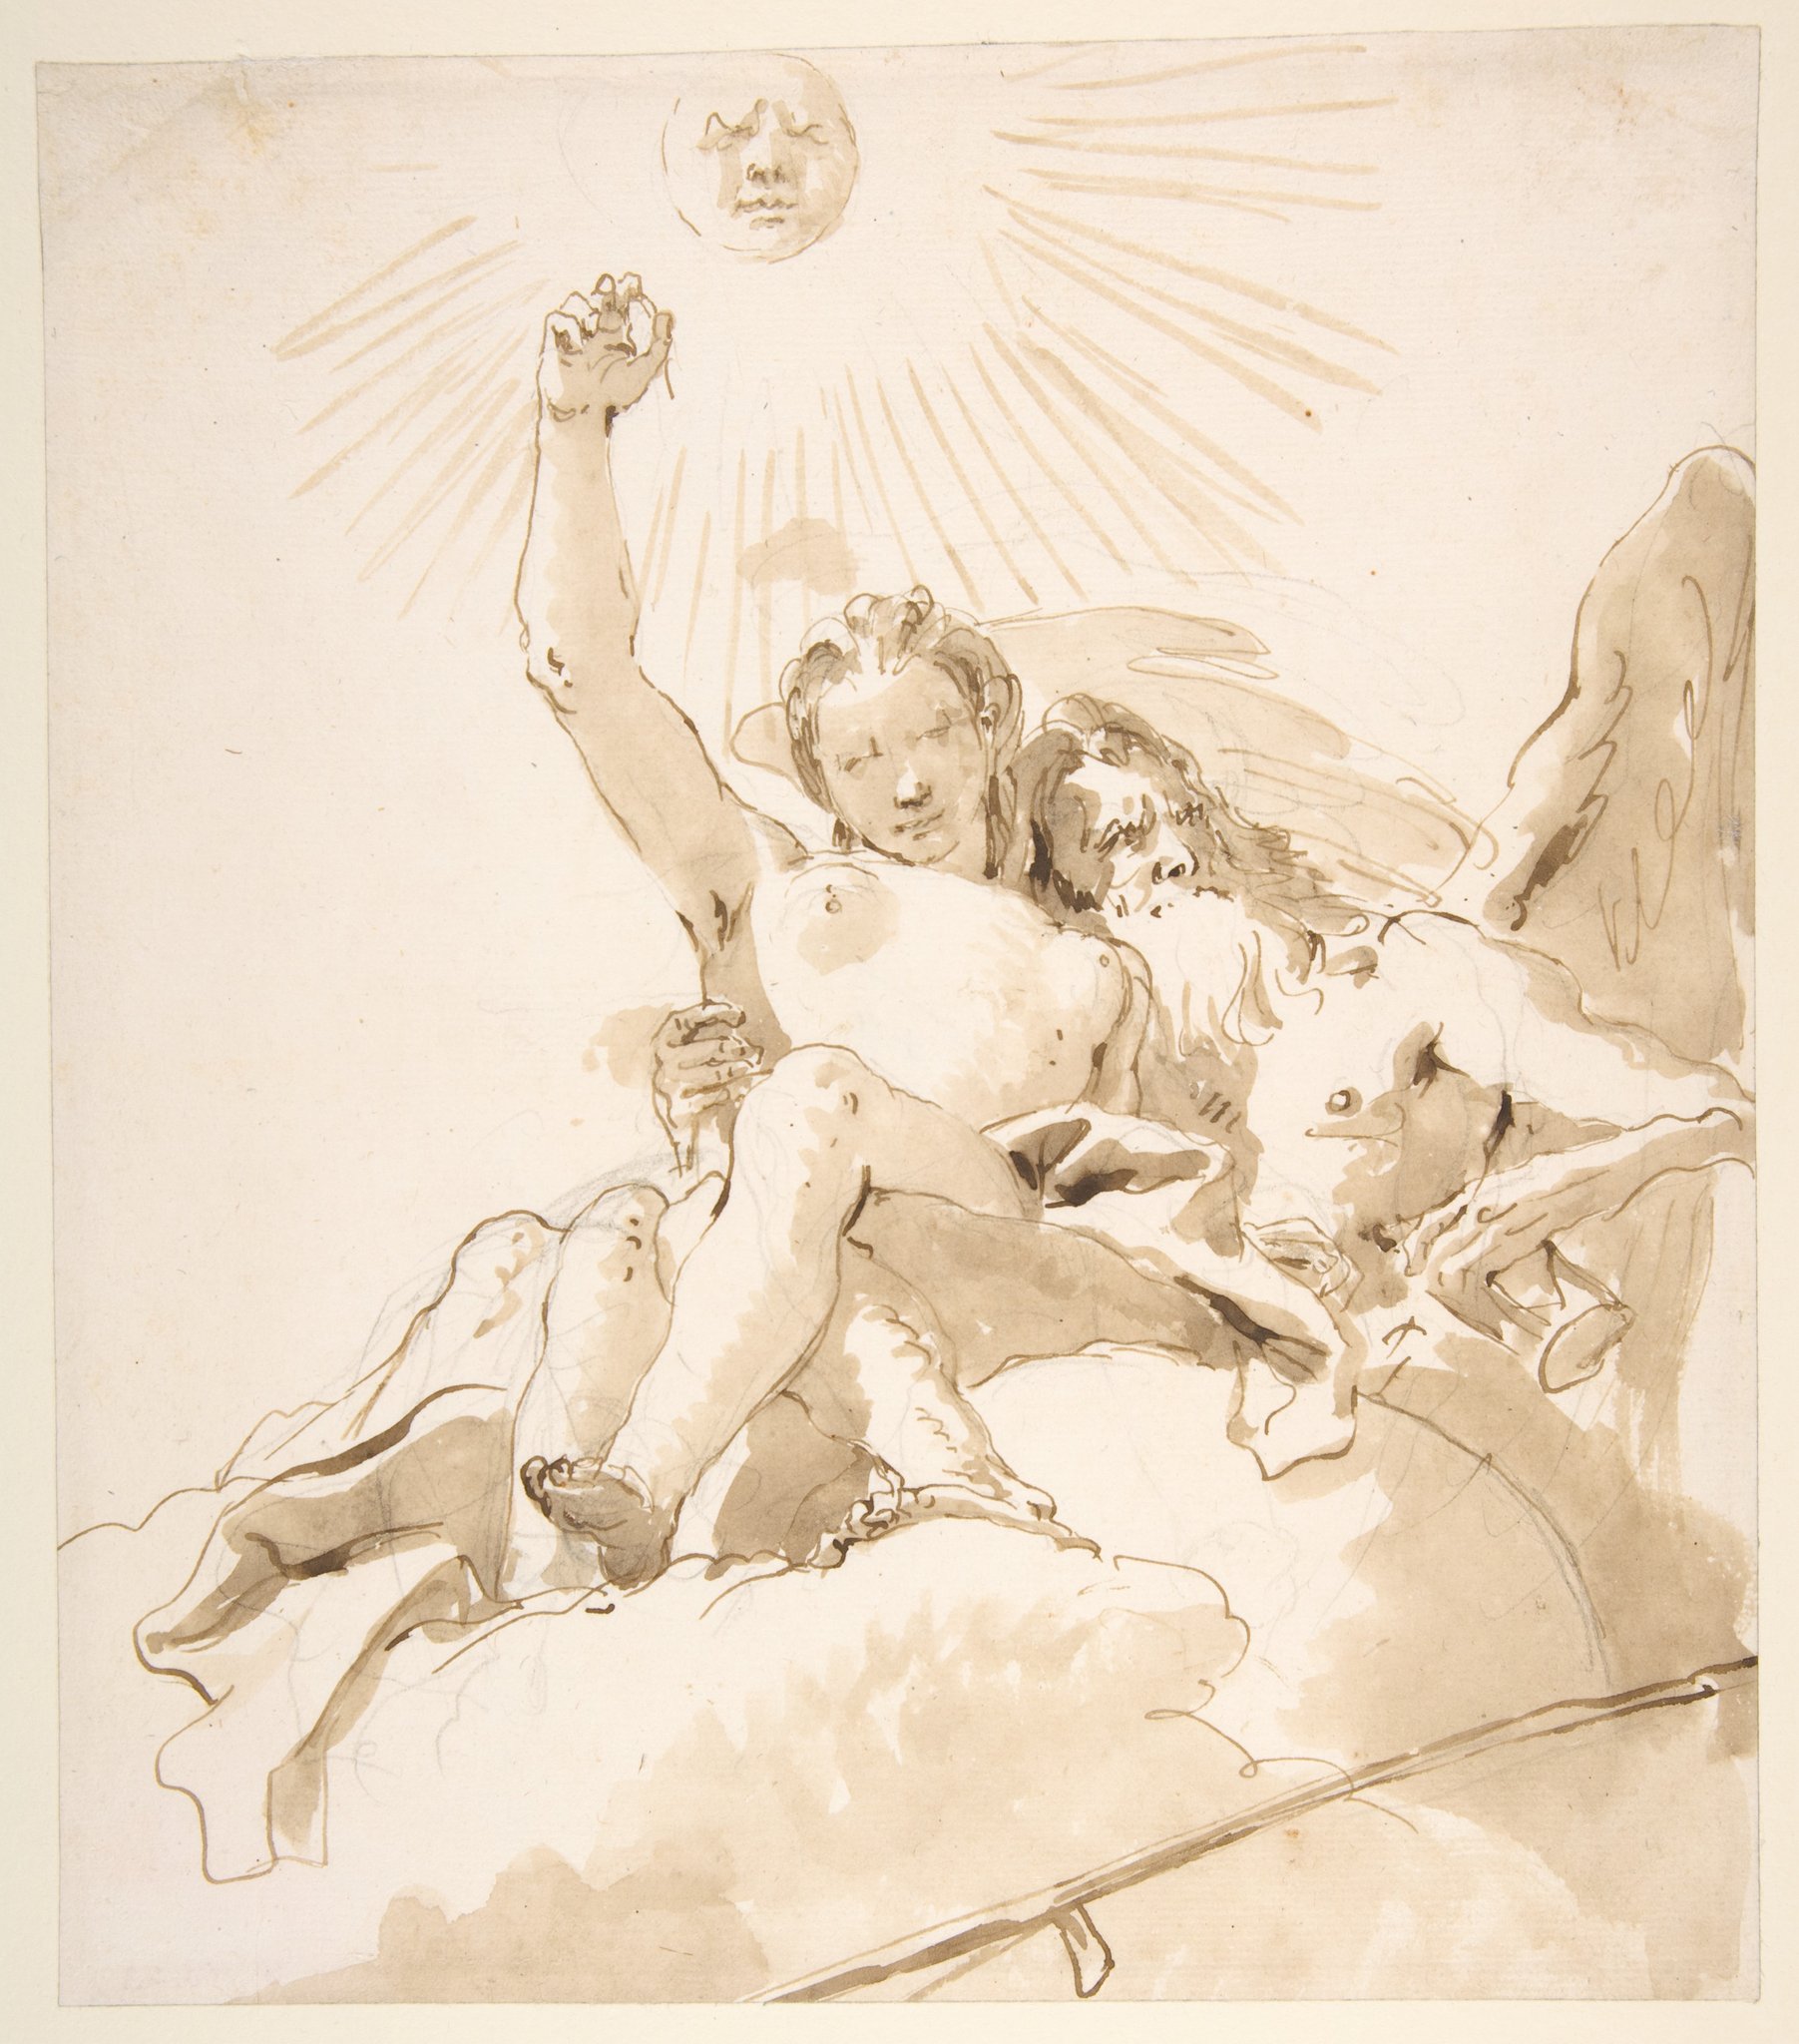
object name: drawing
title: Time and Truth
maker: giovanni battista tiepolo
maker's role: artist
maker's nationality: italian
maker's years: 1696-1770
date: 1696-1770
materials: chalk, ink, drawing material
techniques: brush, pen, wash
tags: male nudes,female nudes,sun